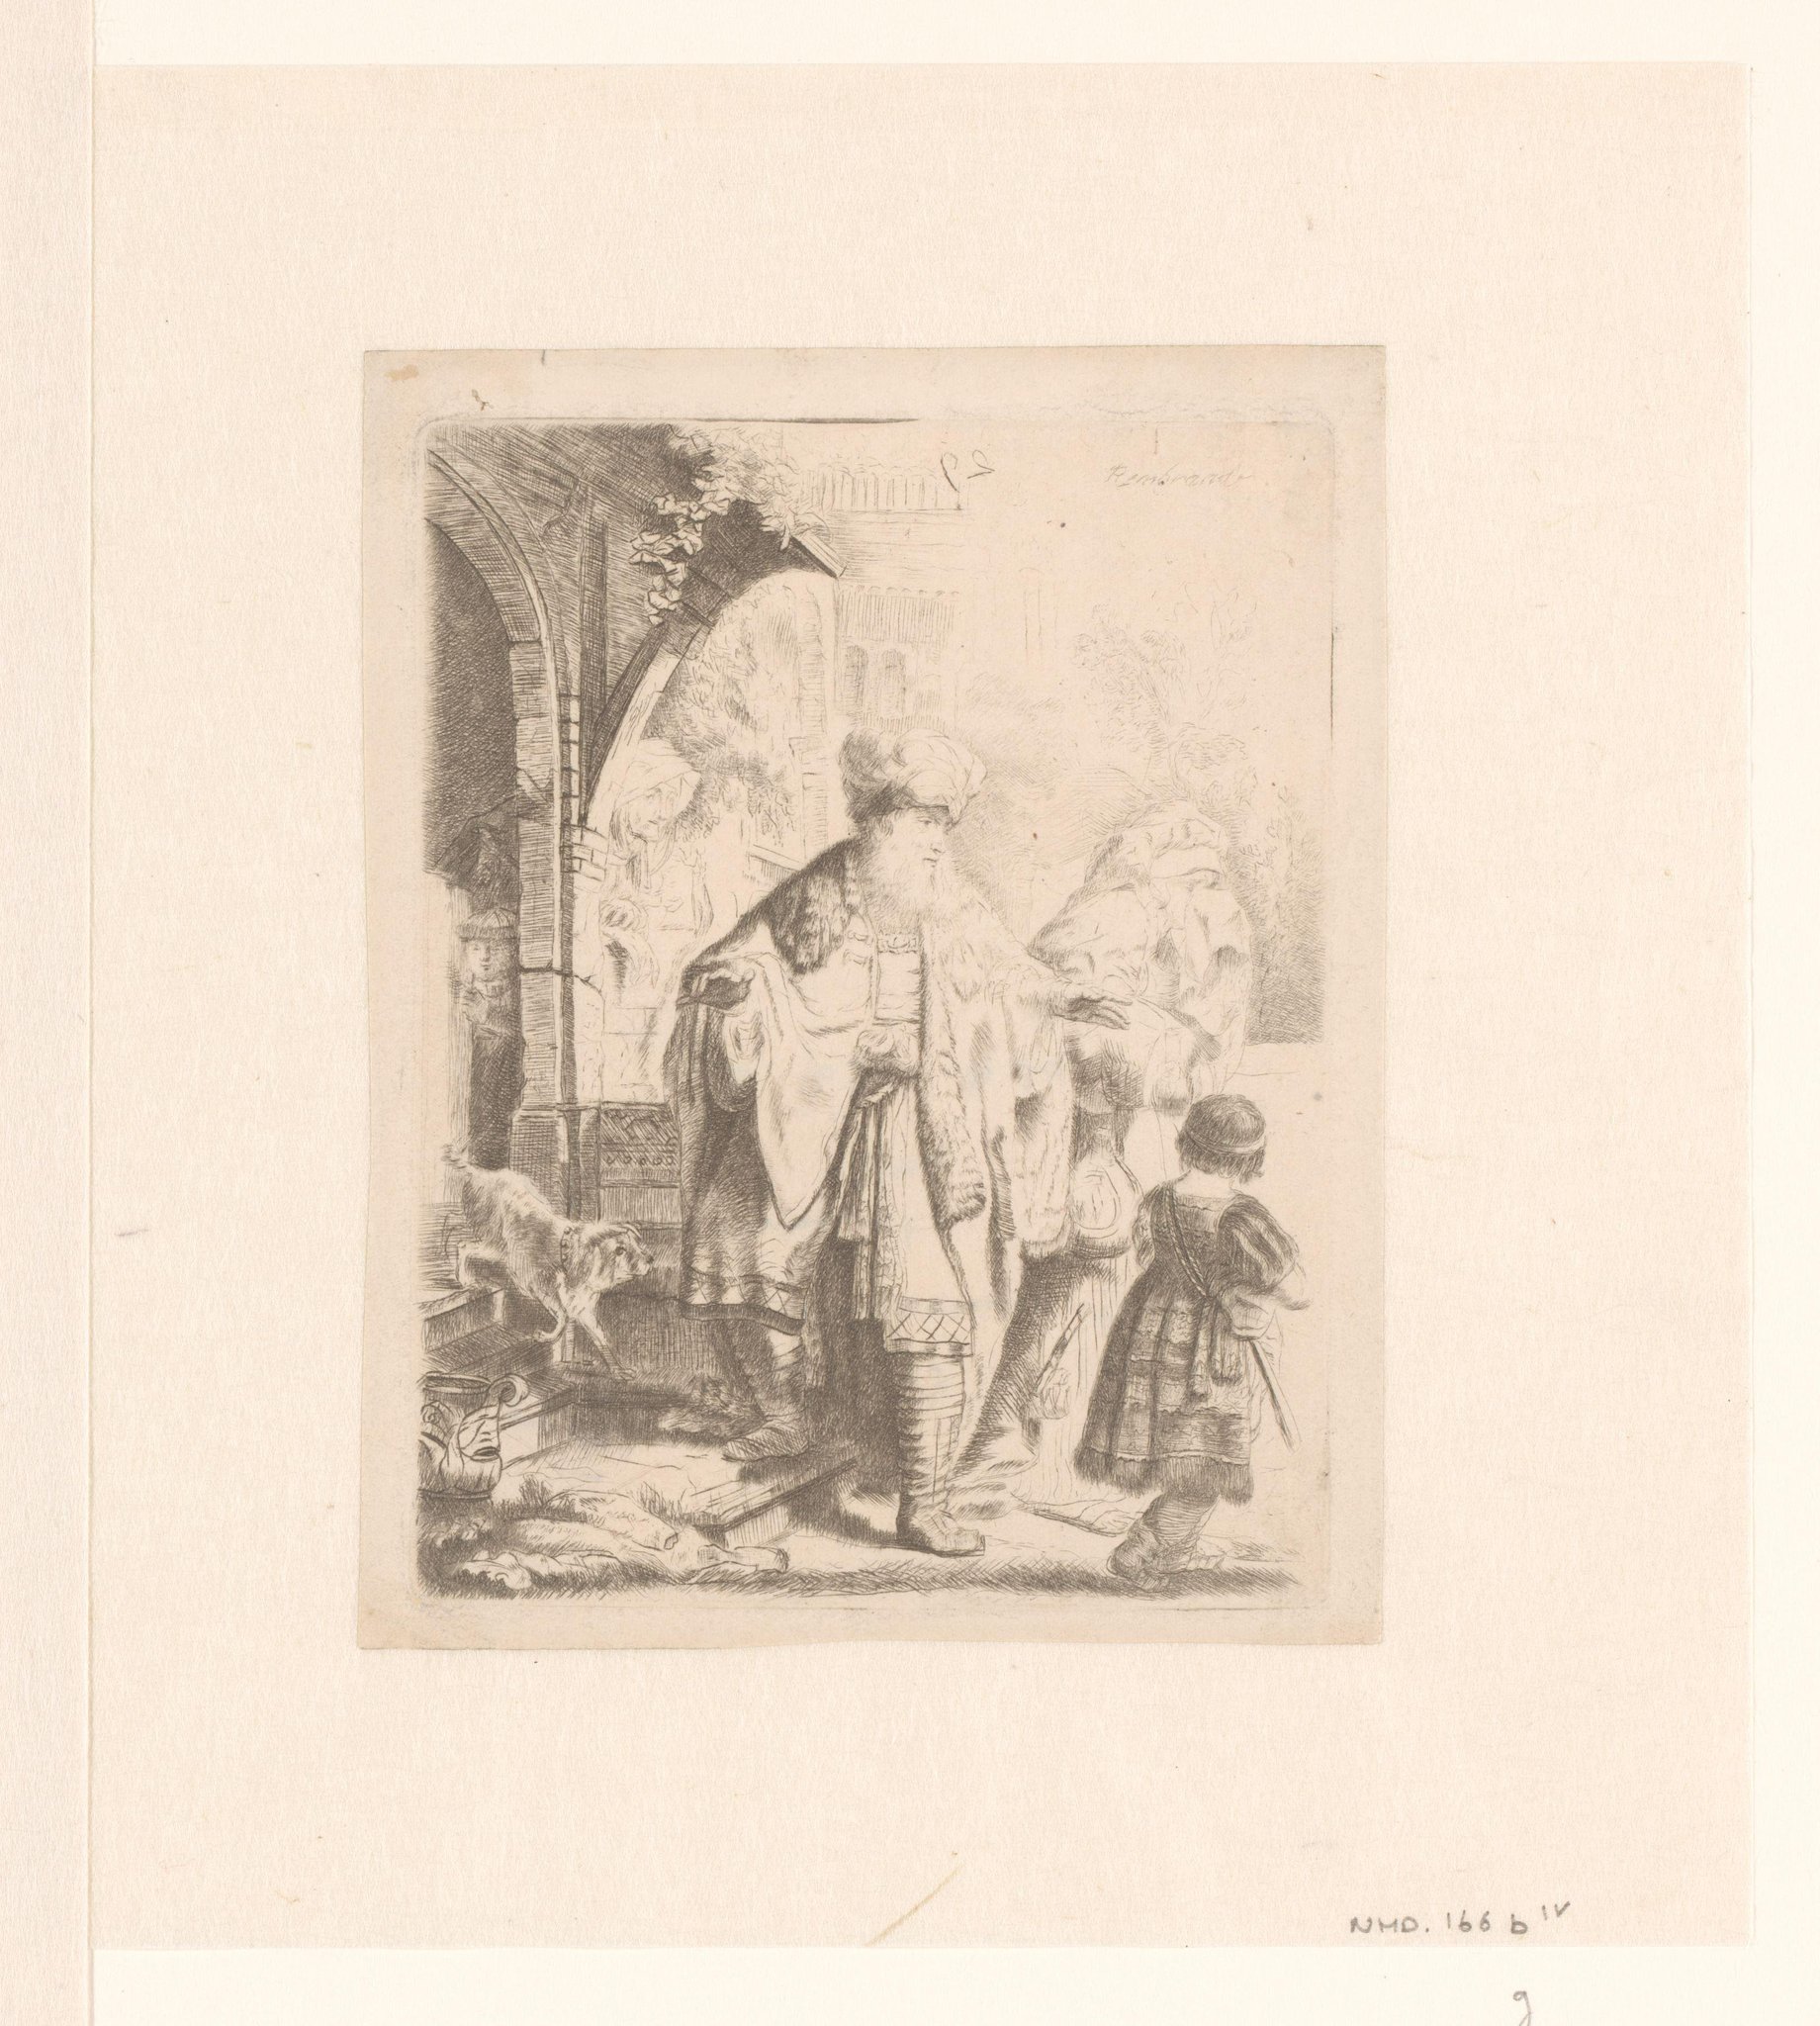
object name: print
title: Abraham casting out Hagar and Ishmael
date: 1710-1766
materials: paper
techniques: etching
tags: the banishment of hagar and ishmael (genesis 21:9-21)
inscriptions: collector's mark: Lugt 2760, collector's mark: Lugt 2228, collector's mark